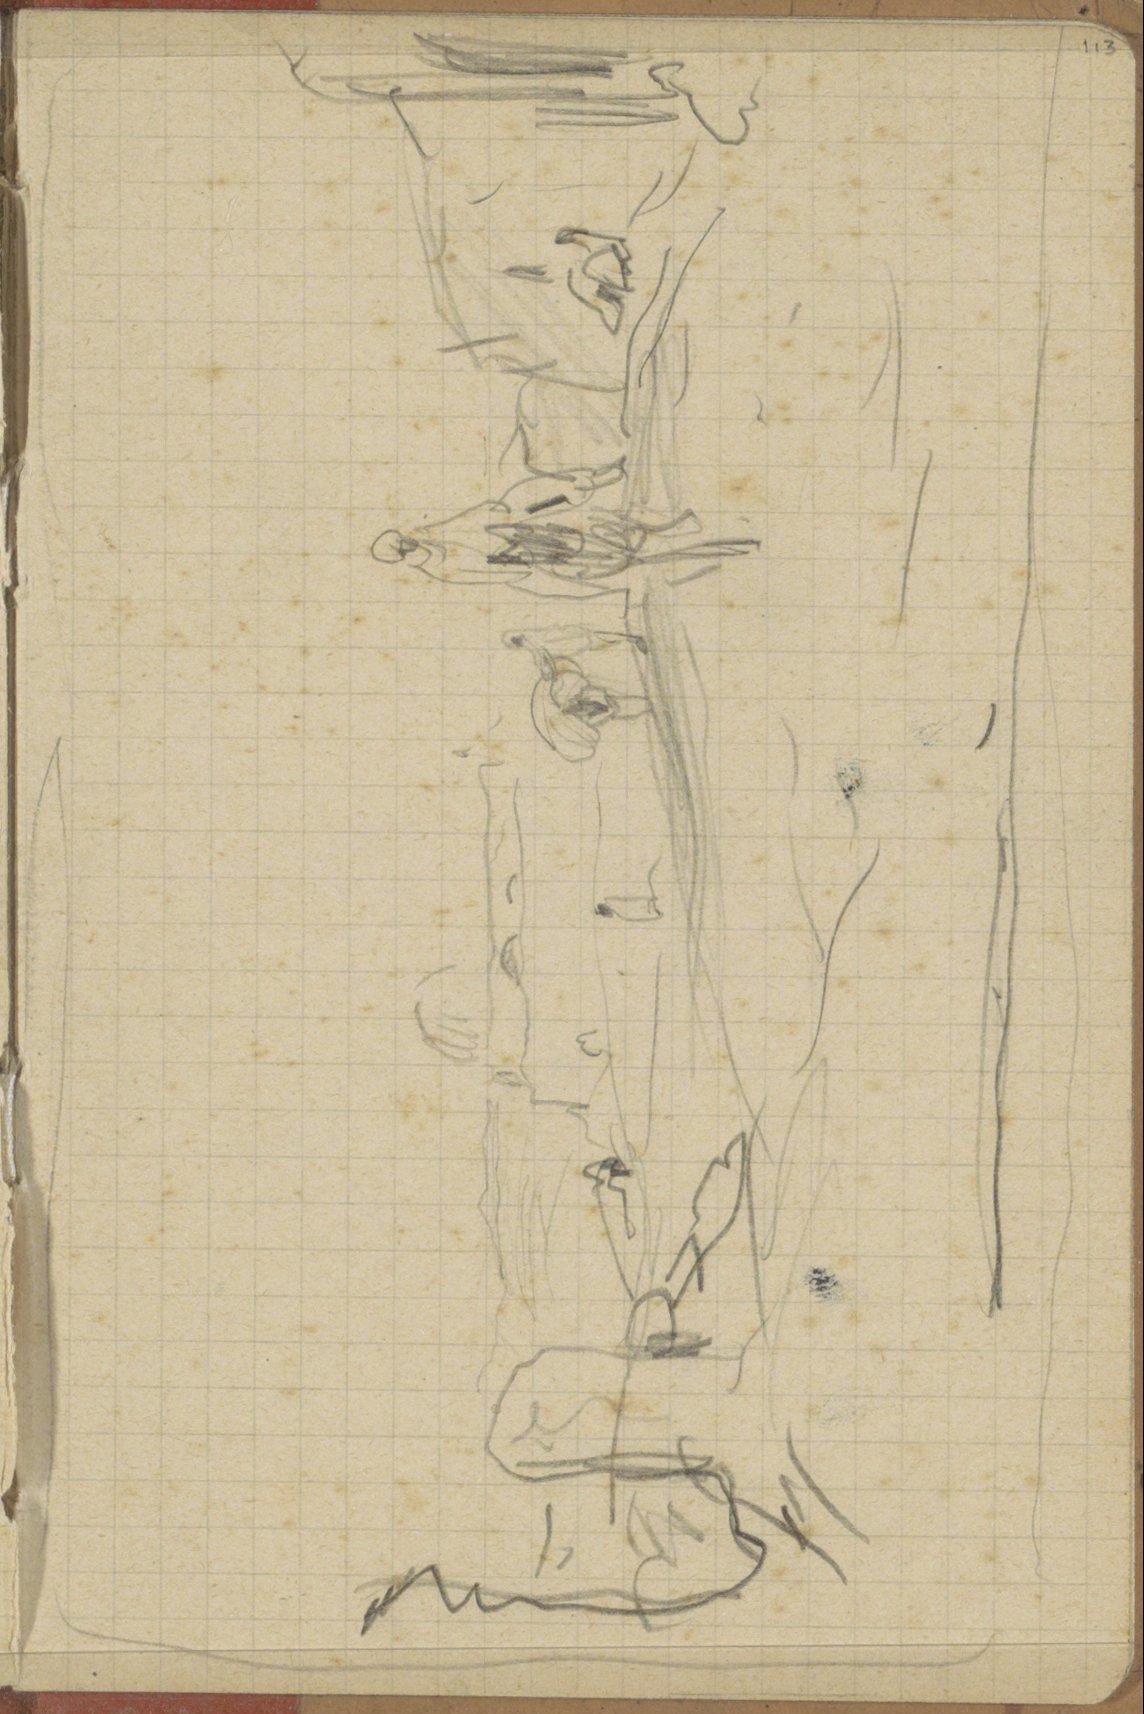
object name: sketchbook leaf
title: Landschap met figuren aan de rand van een stad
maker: marius bauer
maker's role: draughtsman, print maker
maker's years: 1867-1932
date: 1909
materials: pencil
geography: tunisia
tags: riding a horse, ass, or mule; rider, horseman, city-view, and landscape with man-made constructions (+ city(-scape) with figures, staffage)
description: Mogelijk de stad Kairouan. Pagina 113 uit een schetsboek met 67 bladen.